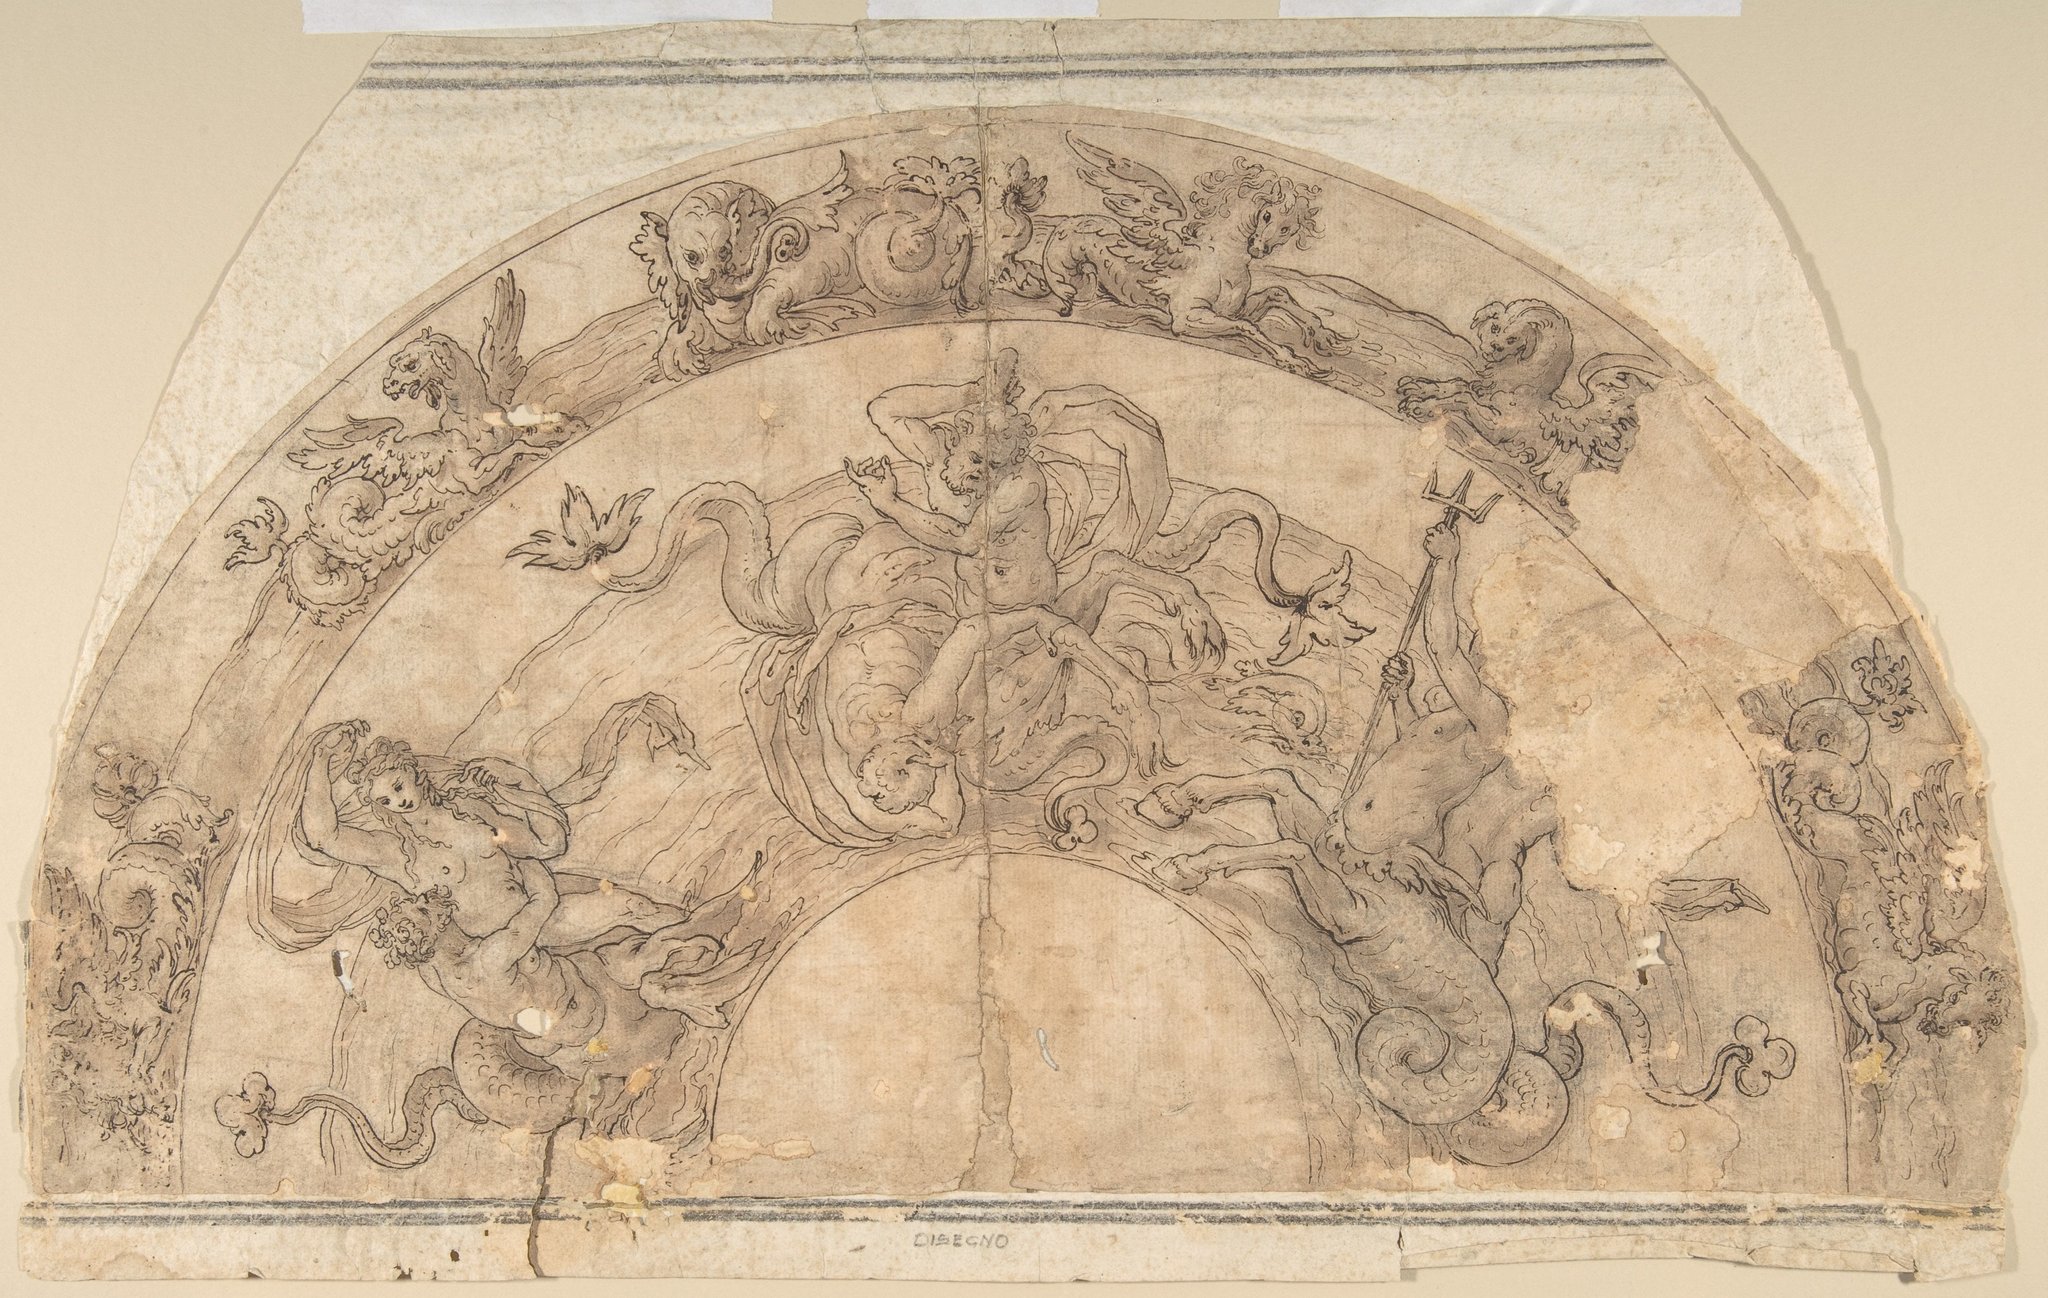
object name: collection ornament architecture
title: Semi-Circular Design of Battle of Sea Gods with Border of Sea Creatures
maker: anonymous, italian, late 16th century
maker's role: artist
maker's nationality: italian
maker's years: 1550-1600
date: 1570-1620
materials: chalk, ink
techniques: brush, pen, wash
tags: battles,mythical creatures